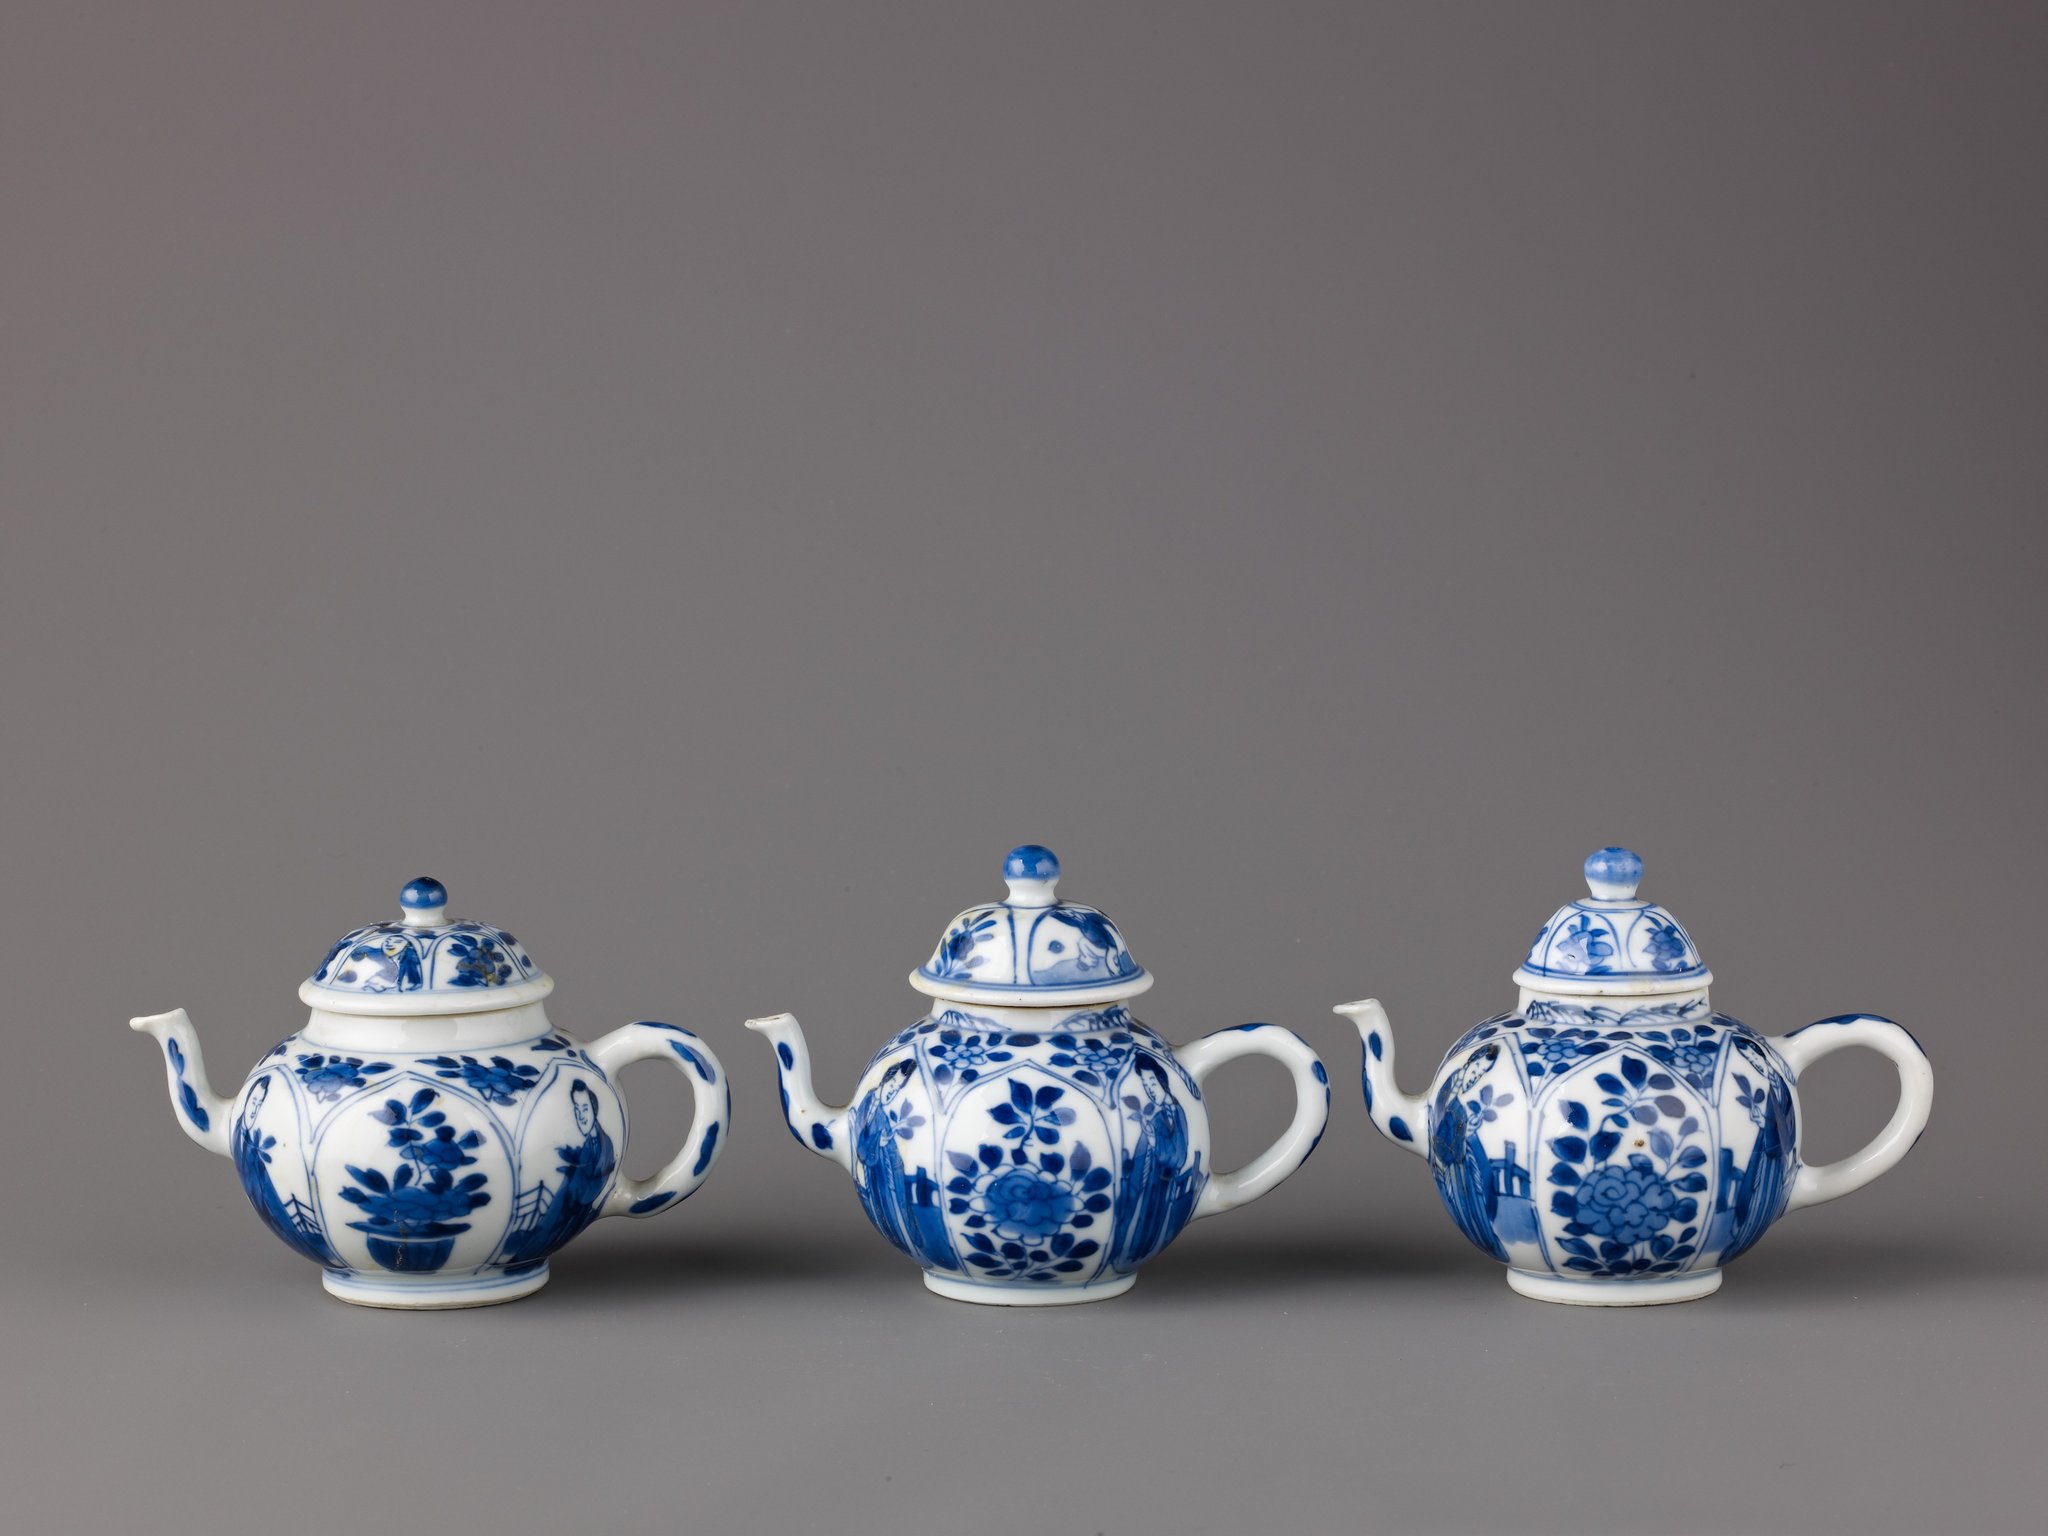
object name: covered winepot or teapot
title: Small covered winepot or teapot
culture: chinese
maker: chinese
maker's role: artist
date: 1662-1722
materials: porcelain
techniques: painting, underglaze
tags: flowers